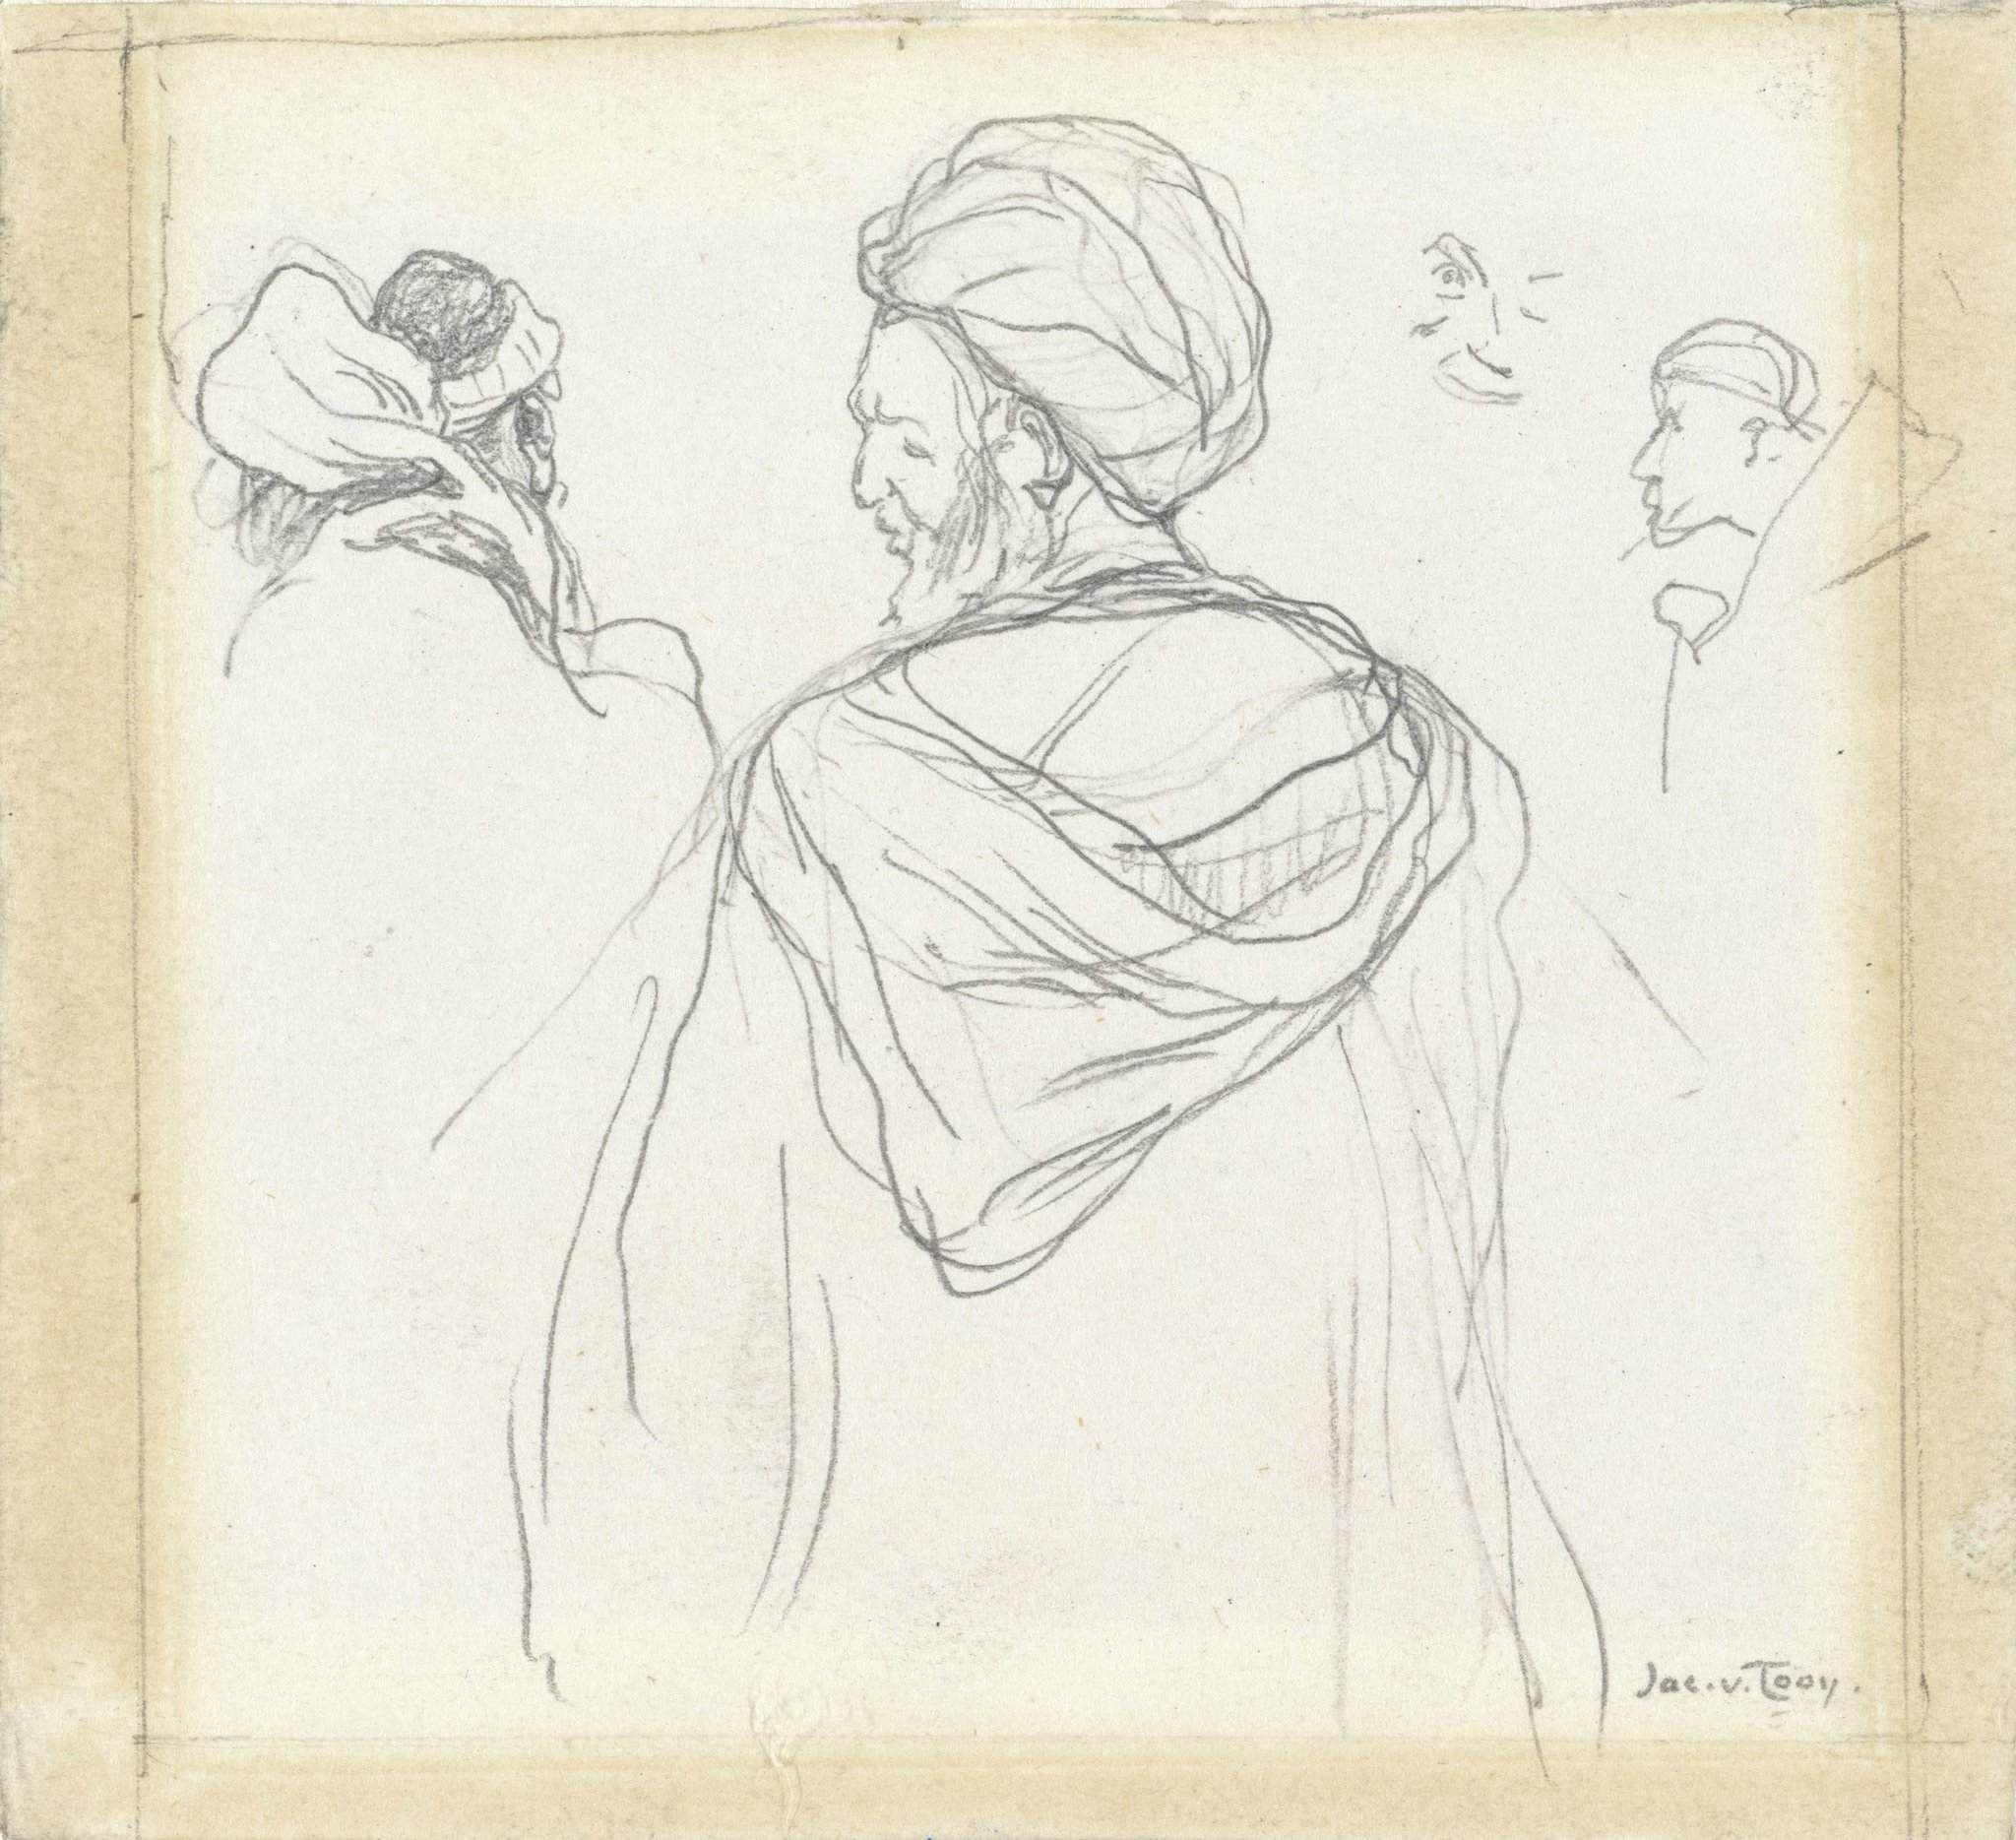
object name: drawing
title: Studies van enkele arabieren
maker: jac van looij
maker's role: draughtsman, painter, print maker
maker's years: 1855-1930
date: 1865-1930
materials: paper, pencil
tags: asiatic races and peoples (with name)